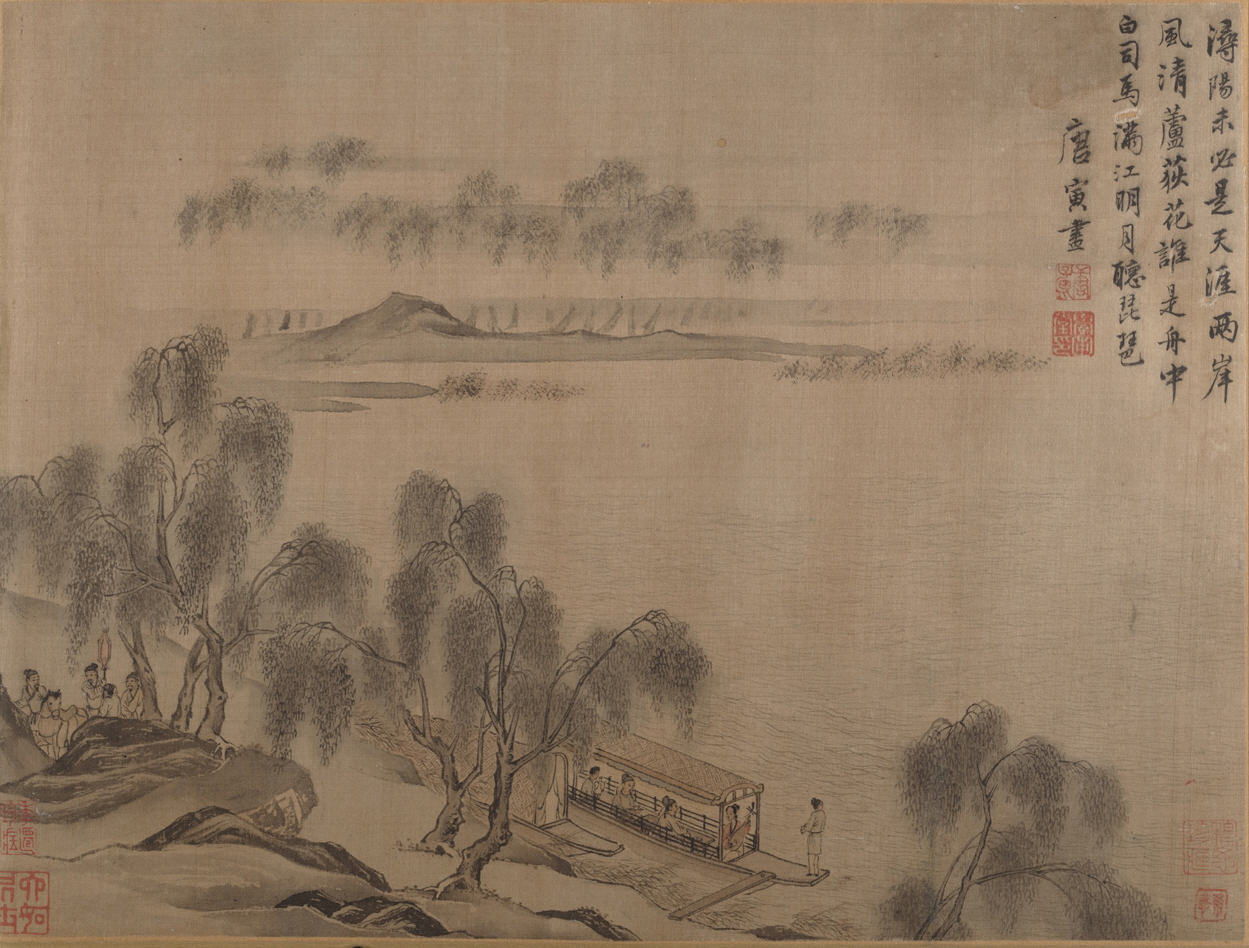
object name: album leaf mounted a a handscroll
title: Landscapes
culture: chinese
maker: tang yin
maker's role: artist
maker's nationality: chinese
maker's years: 1470-1524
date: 1470-1524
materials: ink, silk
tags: human figures,landscapes,boats